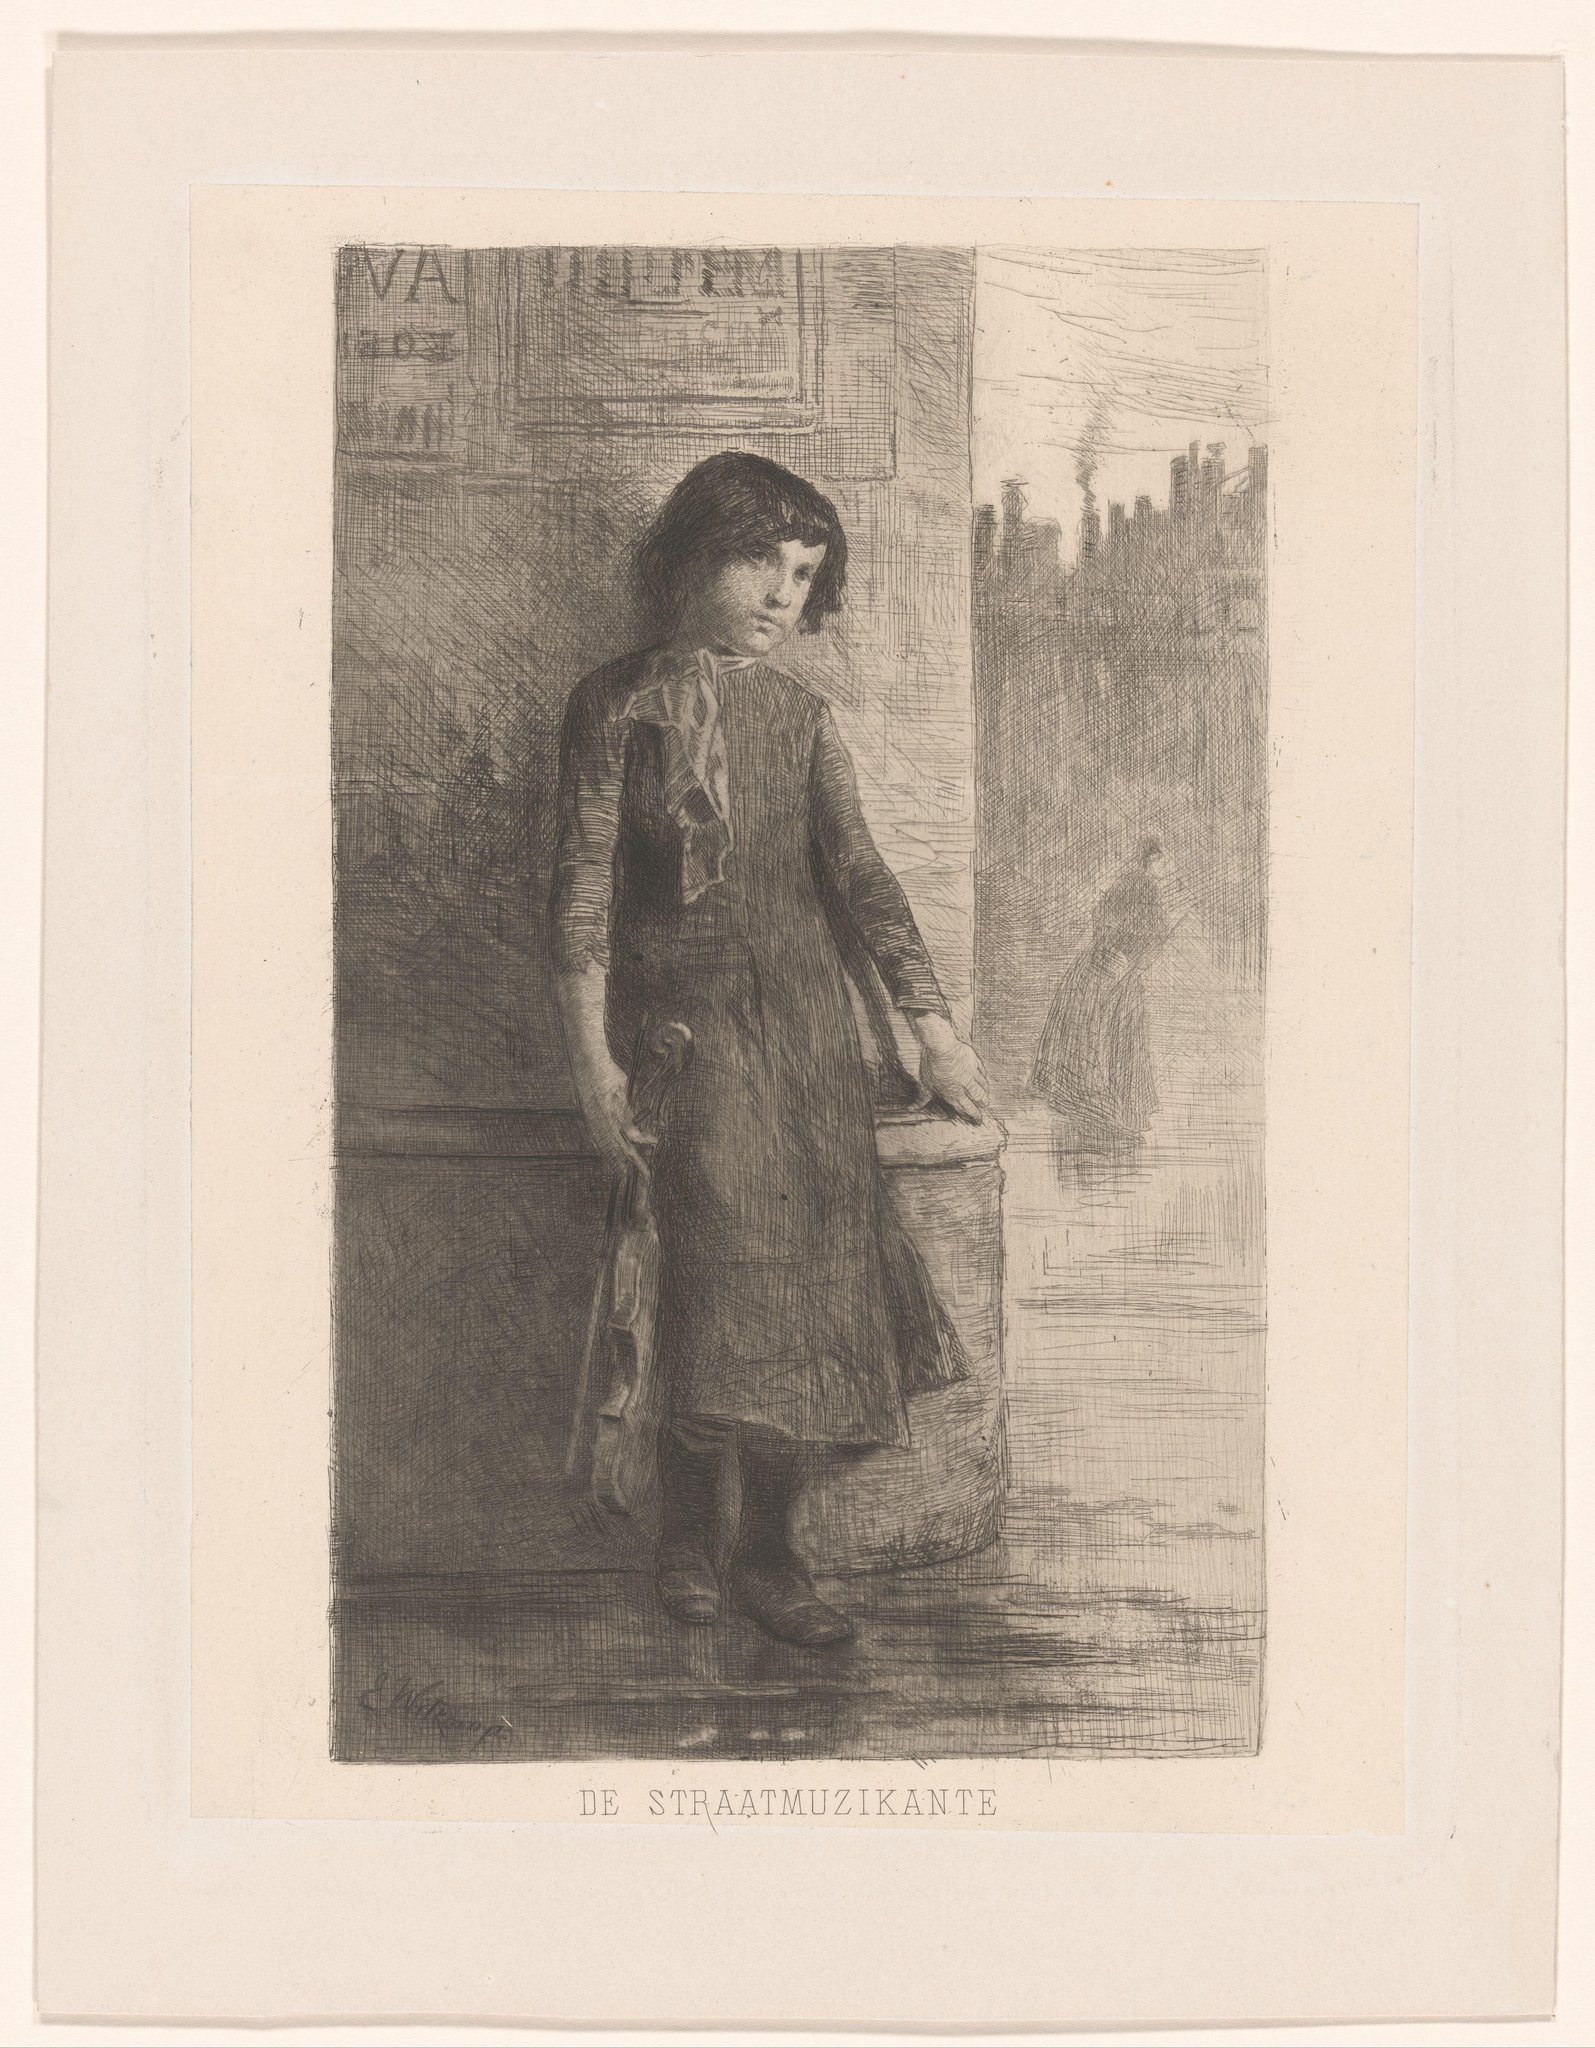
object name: print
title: Jonge straatmuzikante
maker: ernst witkamp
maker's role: draughtsman, print maker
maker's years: 1854-1897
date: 1887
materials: paper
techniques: drypoint, etching, intaglio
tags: musician - cc - out of doors, popular music, street music, street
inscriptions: inscription: ‘distel 1887’, collector's mark: Lugt 2228